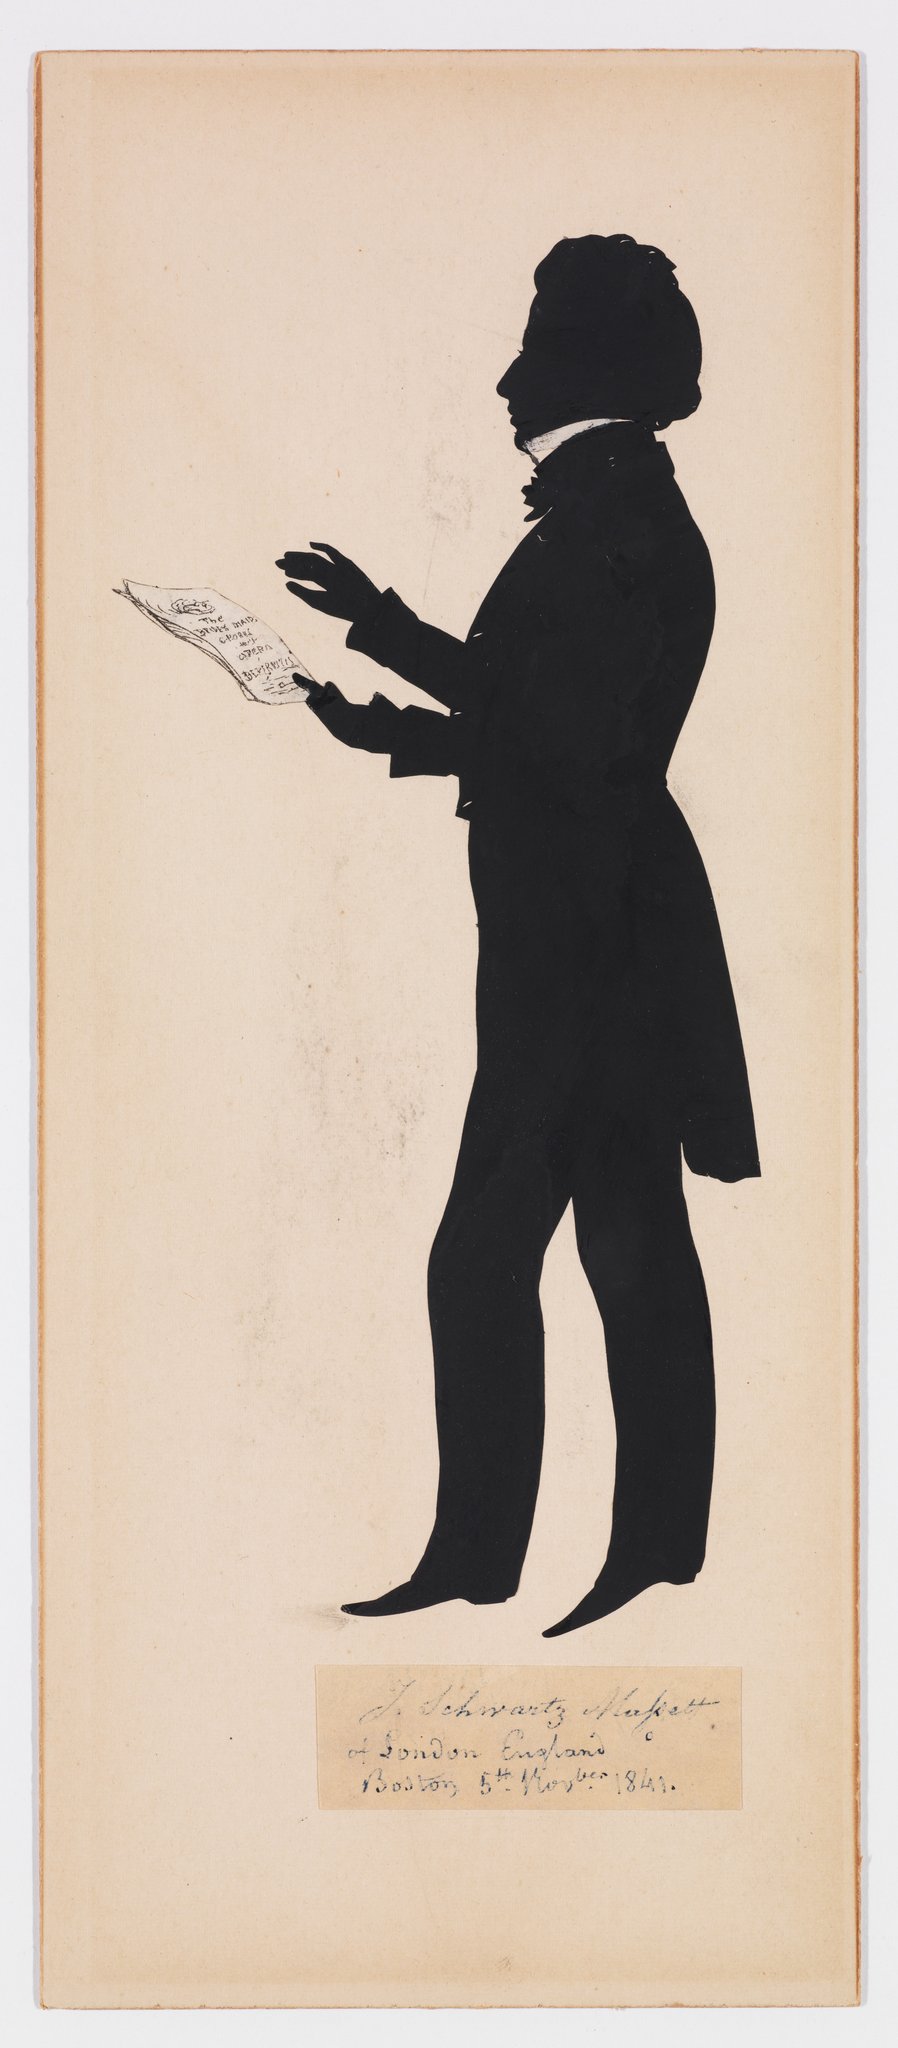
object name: cut paper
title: J. Schwartz Massett of London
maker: auguste edouart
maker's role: artist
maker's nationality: french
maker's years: 1789-1861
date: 1841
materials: paper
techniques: cutting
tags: men